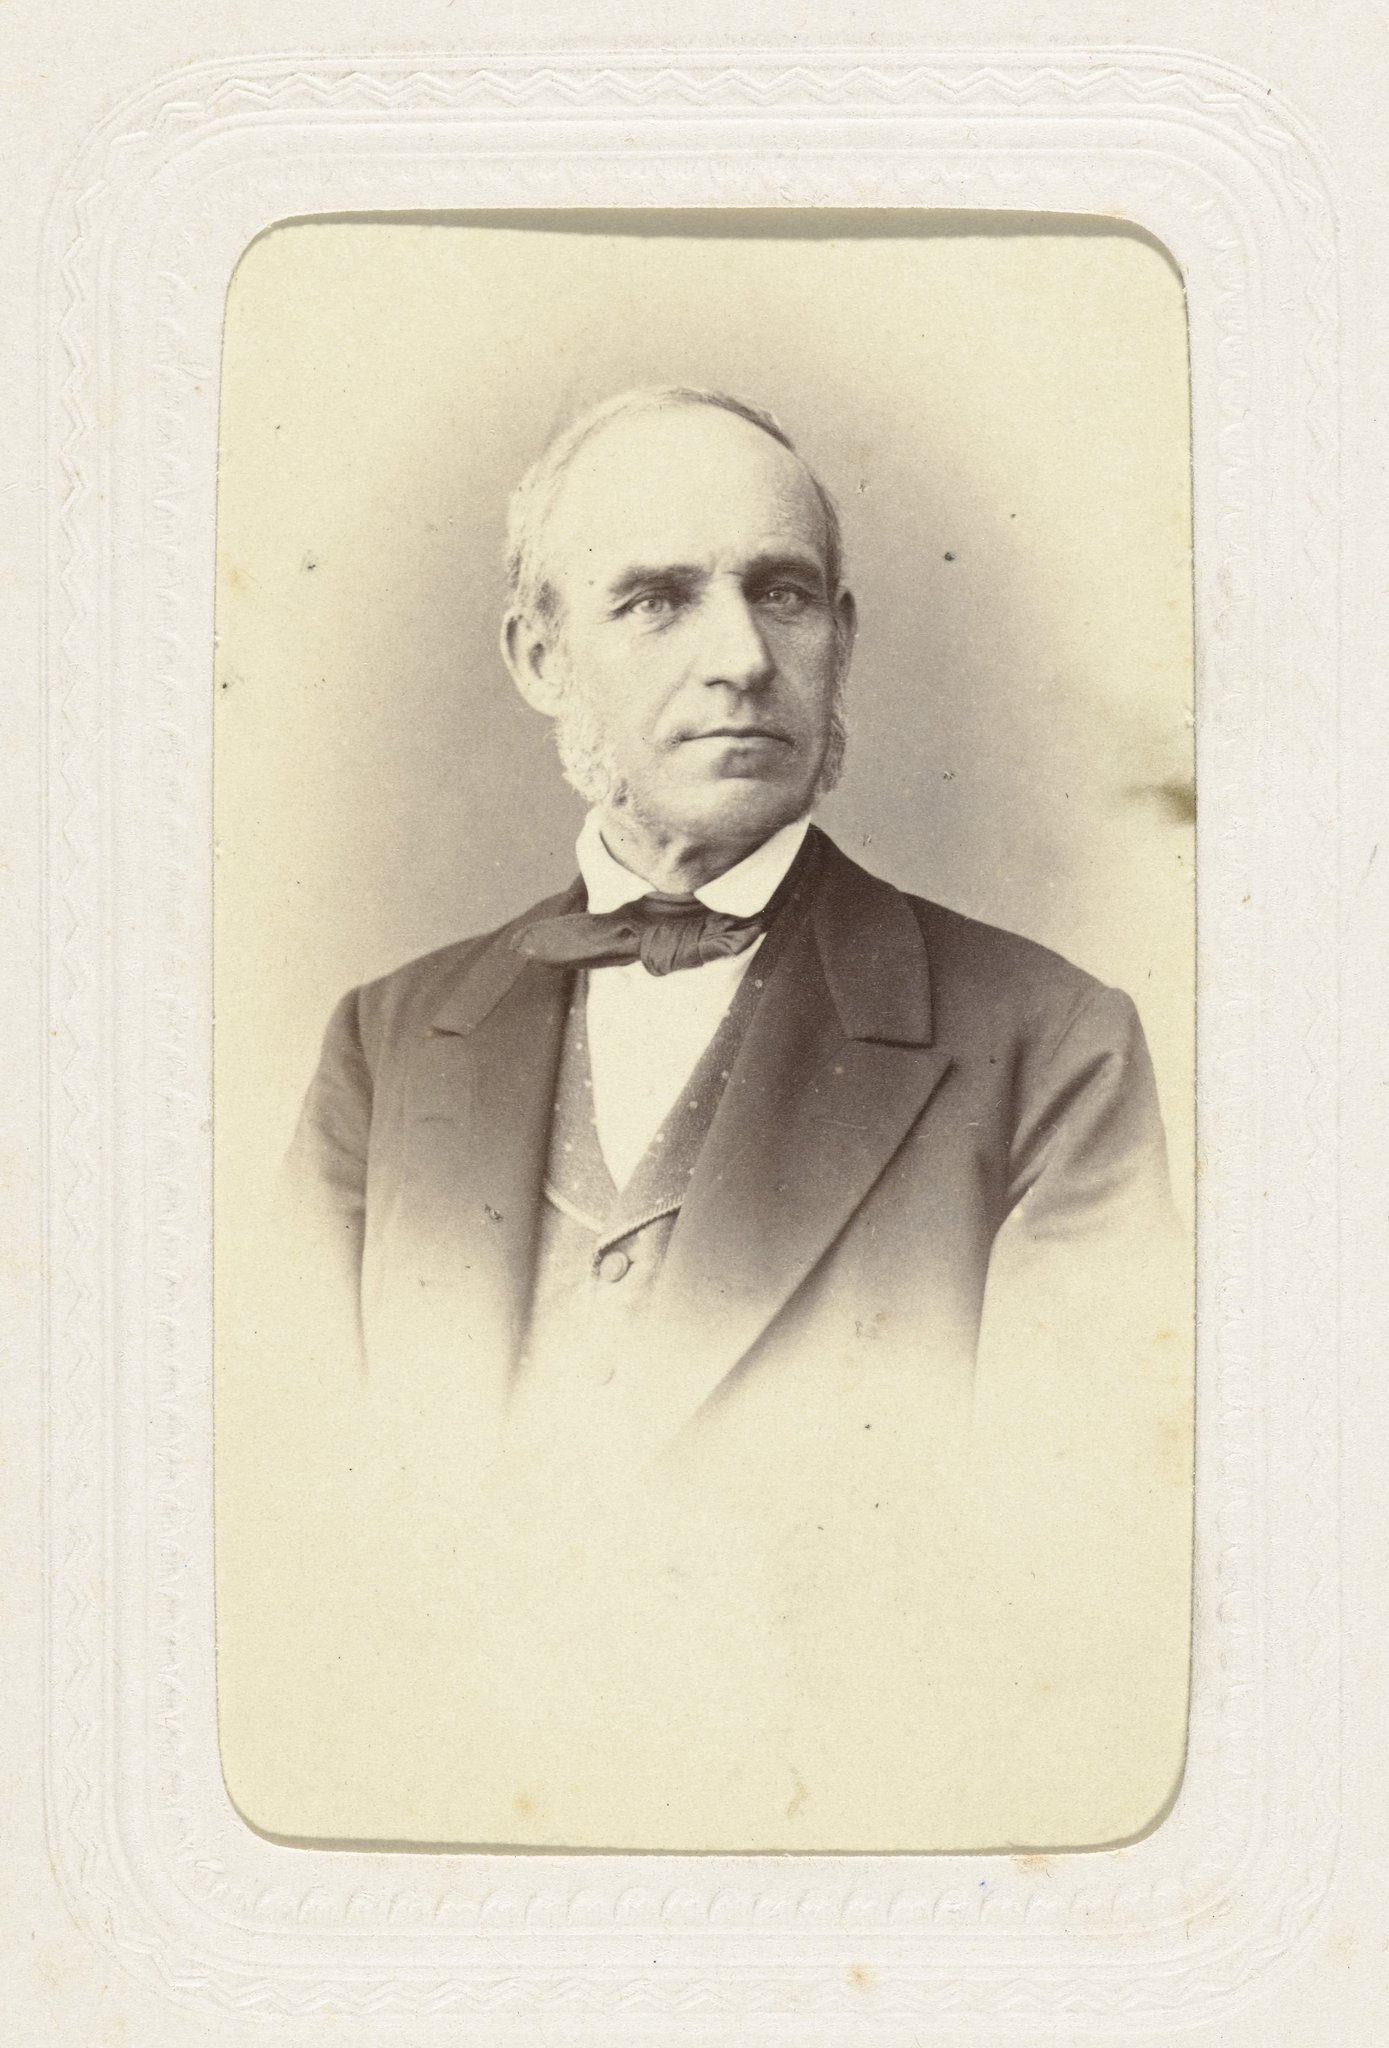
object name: carte de visite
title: Studioportret van een man met grote bakkebaarden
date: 1863-1866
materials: cardboard, paper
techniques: albumen print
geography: istanbul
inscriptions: name: ‘Abdullah freres, Constantinople’